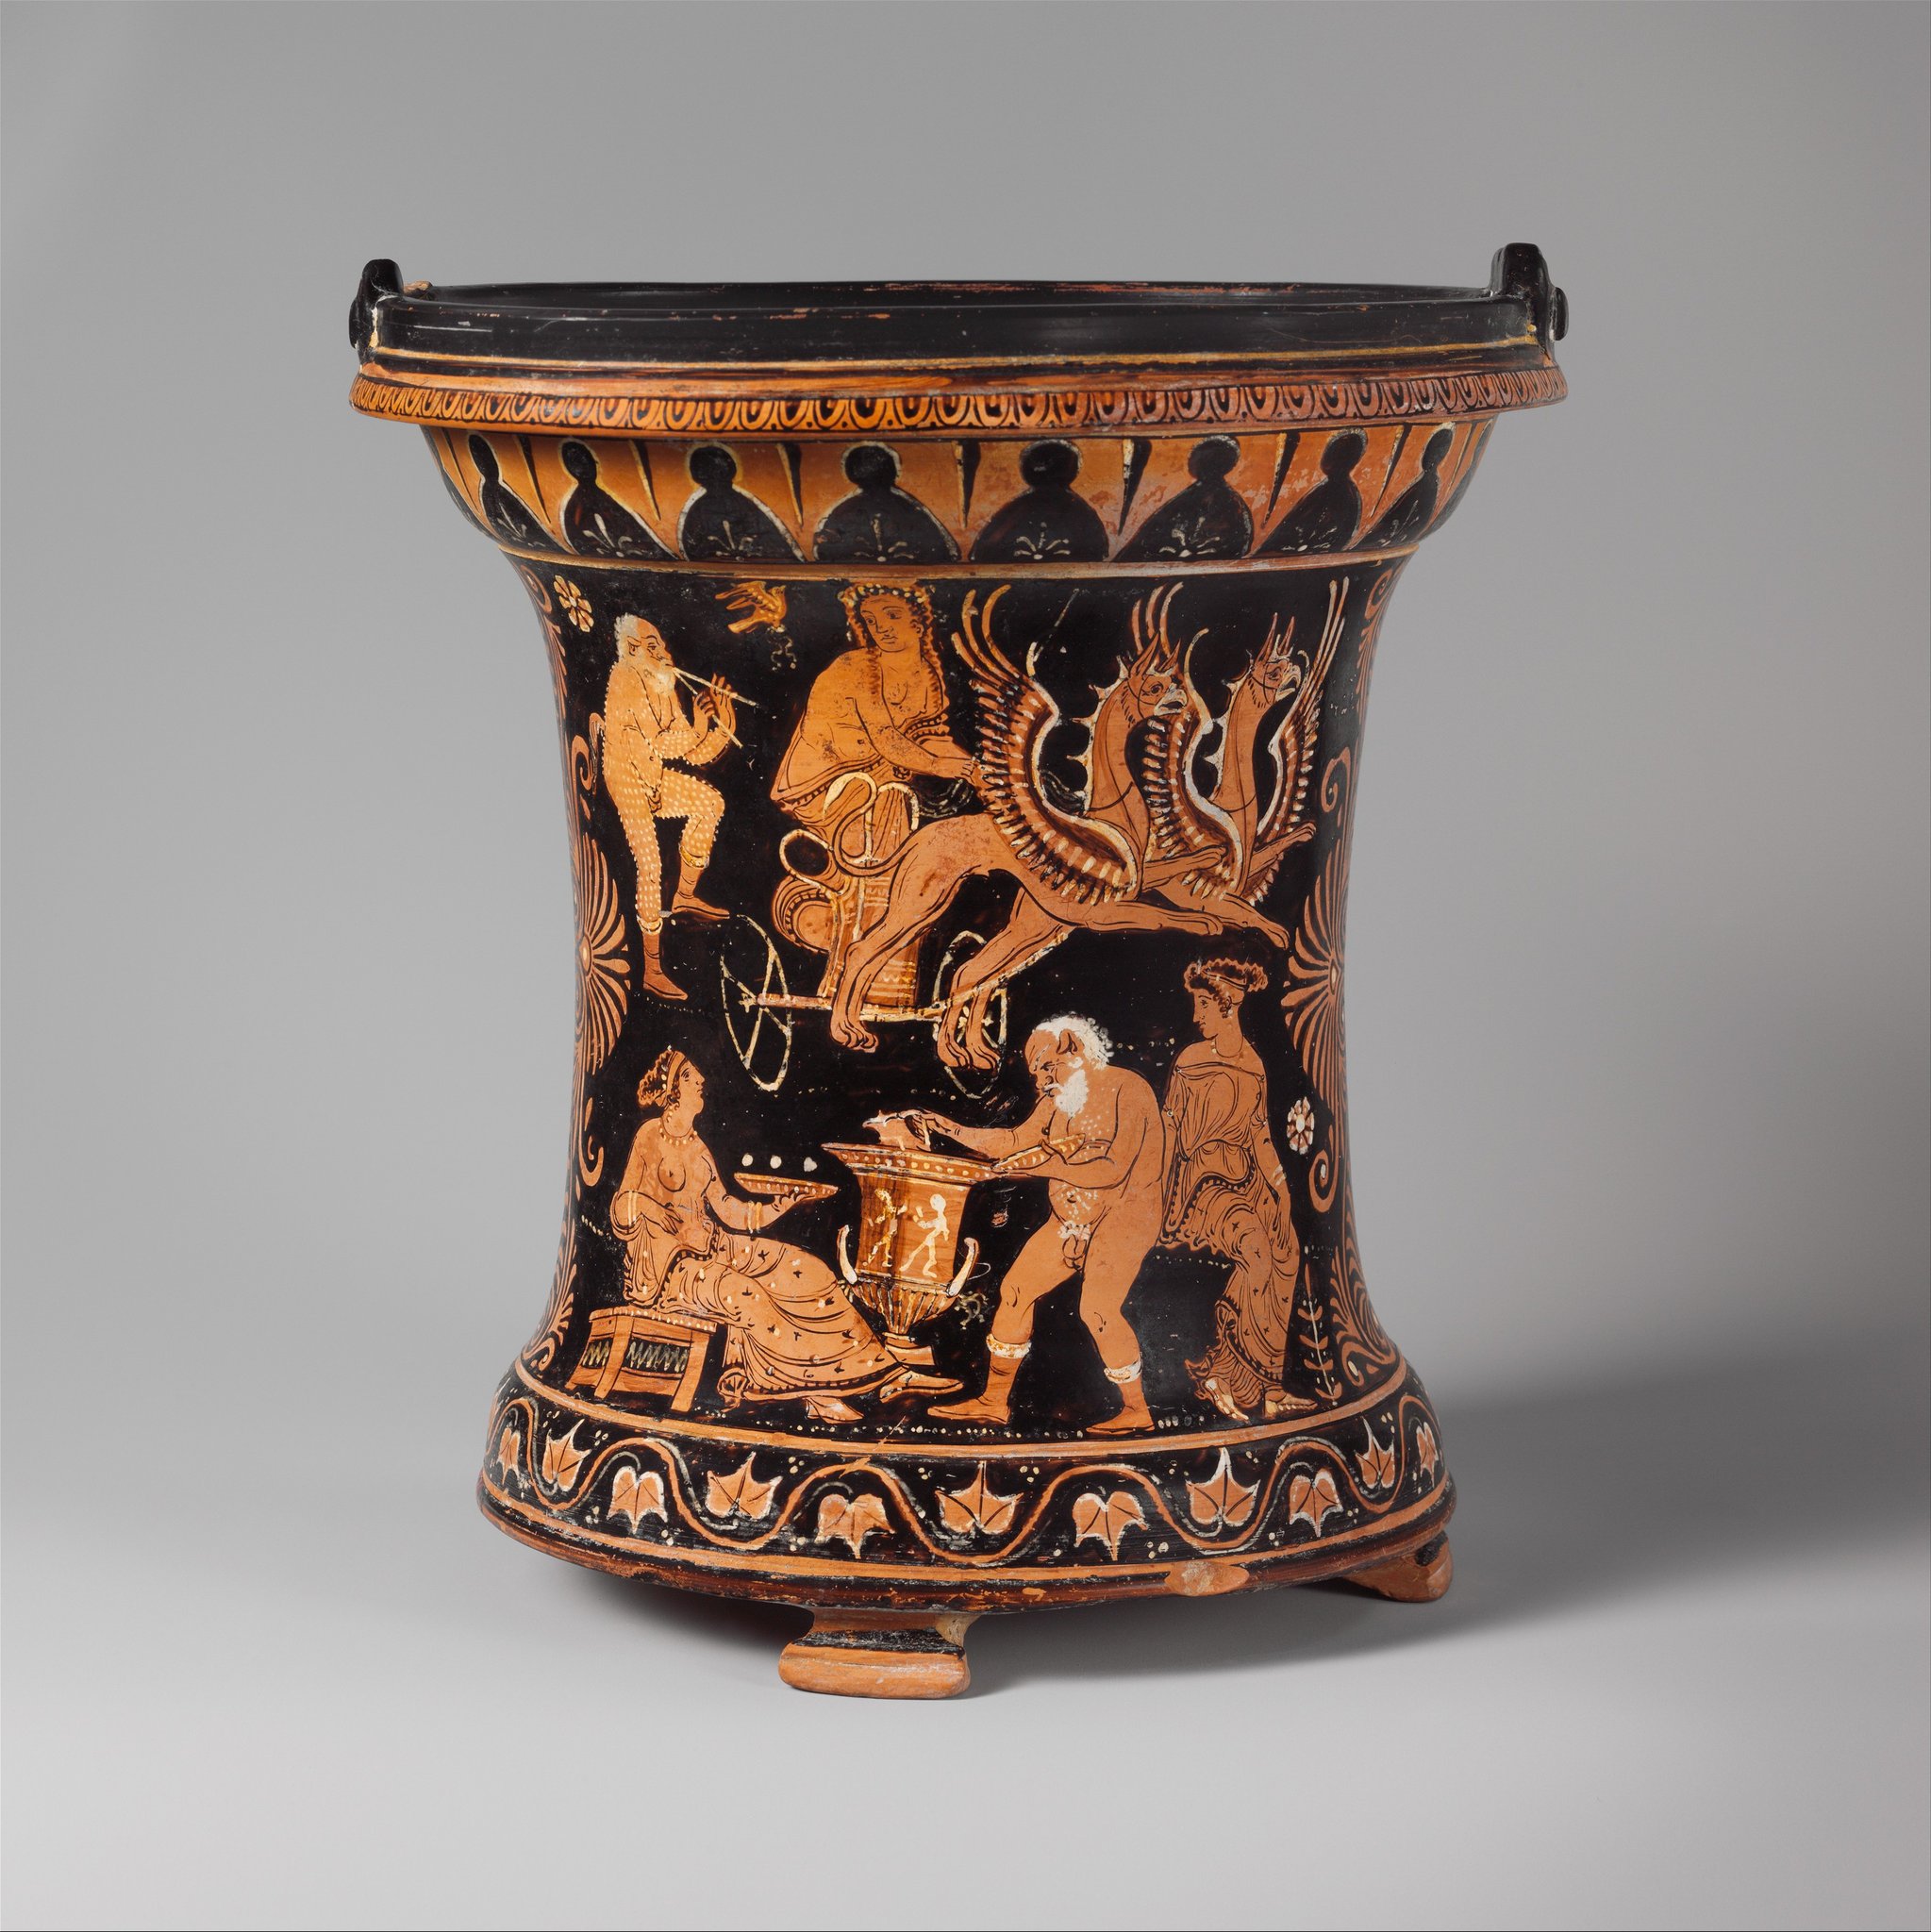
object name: situla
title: Terracotta situla (bucket)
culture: greek, south italian, apulian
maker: lycurgus painter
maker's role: artist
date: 360-340 BCE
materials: terracotta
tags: dionysus,maenads,griffins,satyrs,chariots